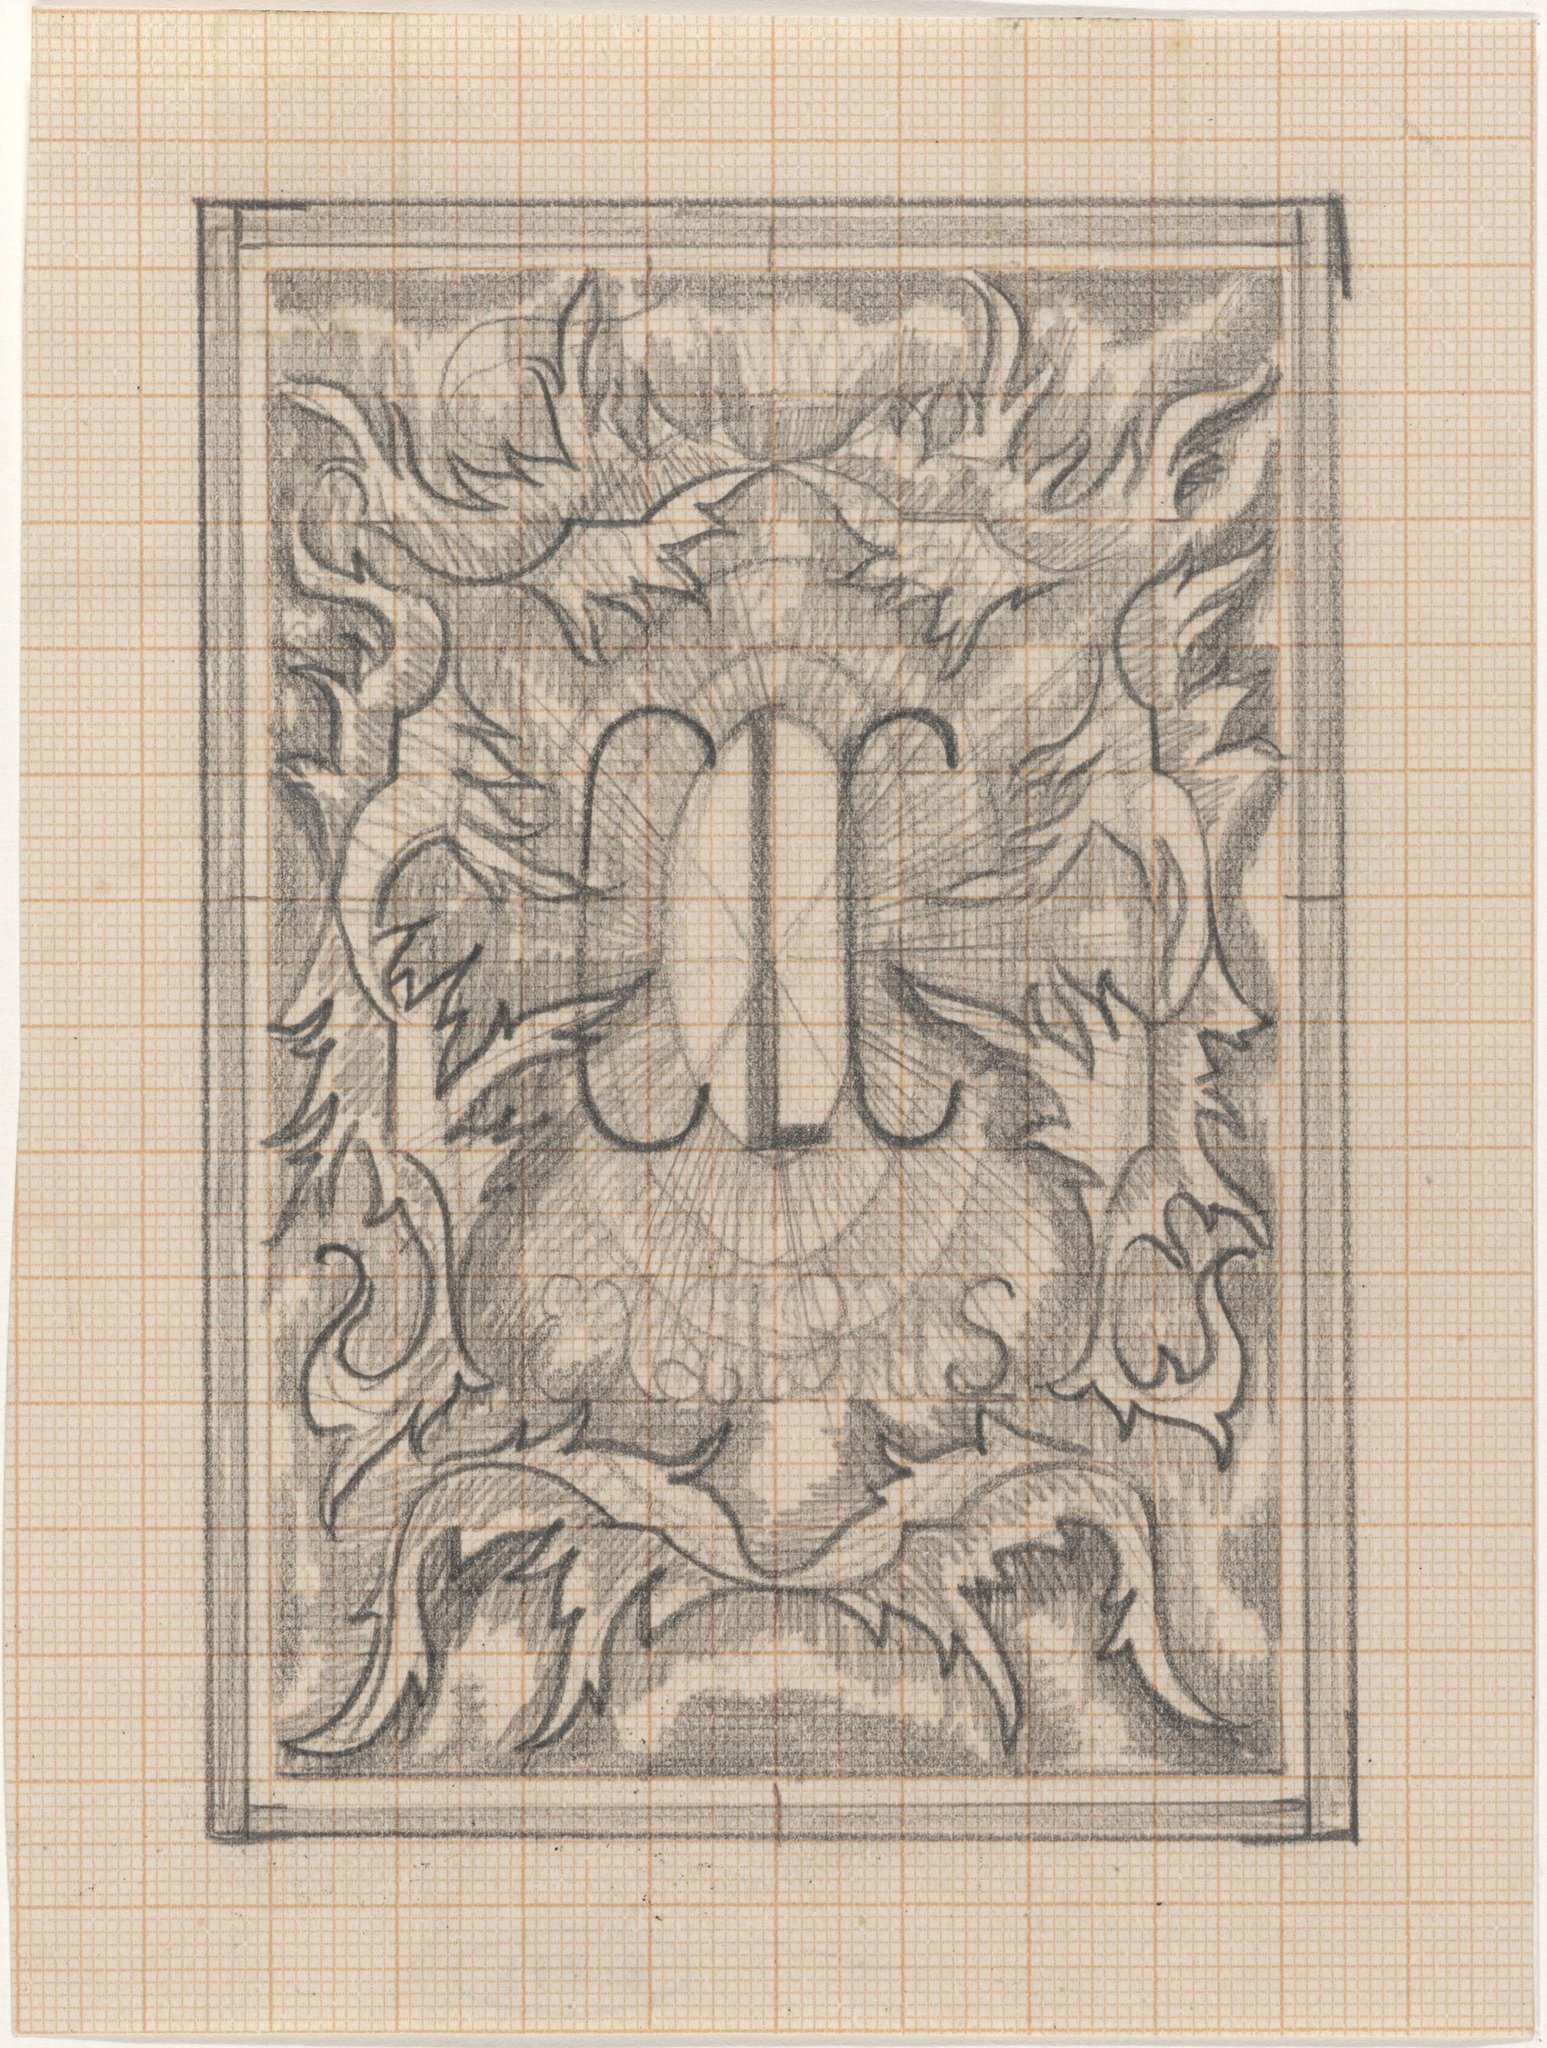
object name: drawing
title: Ontwerp voor ex libris van Carel Lion Cachet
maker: carel adolph lion cachet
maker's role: draughtsman, print maker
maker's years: 1864-1945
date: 1874-1945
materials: pencil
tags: ex-libris